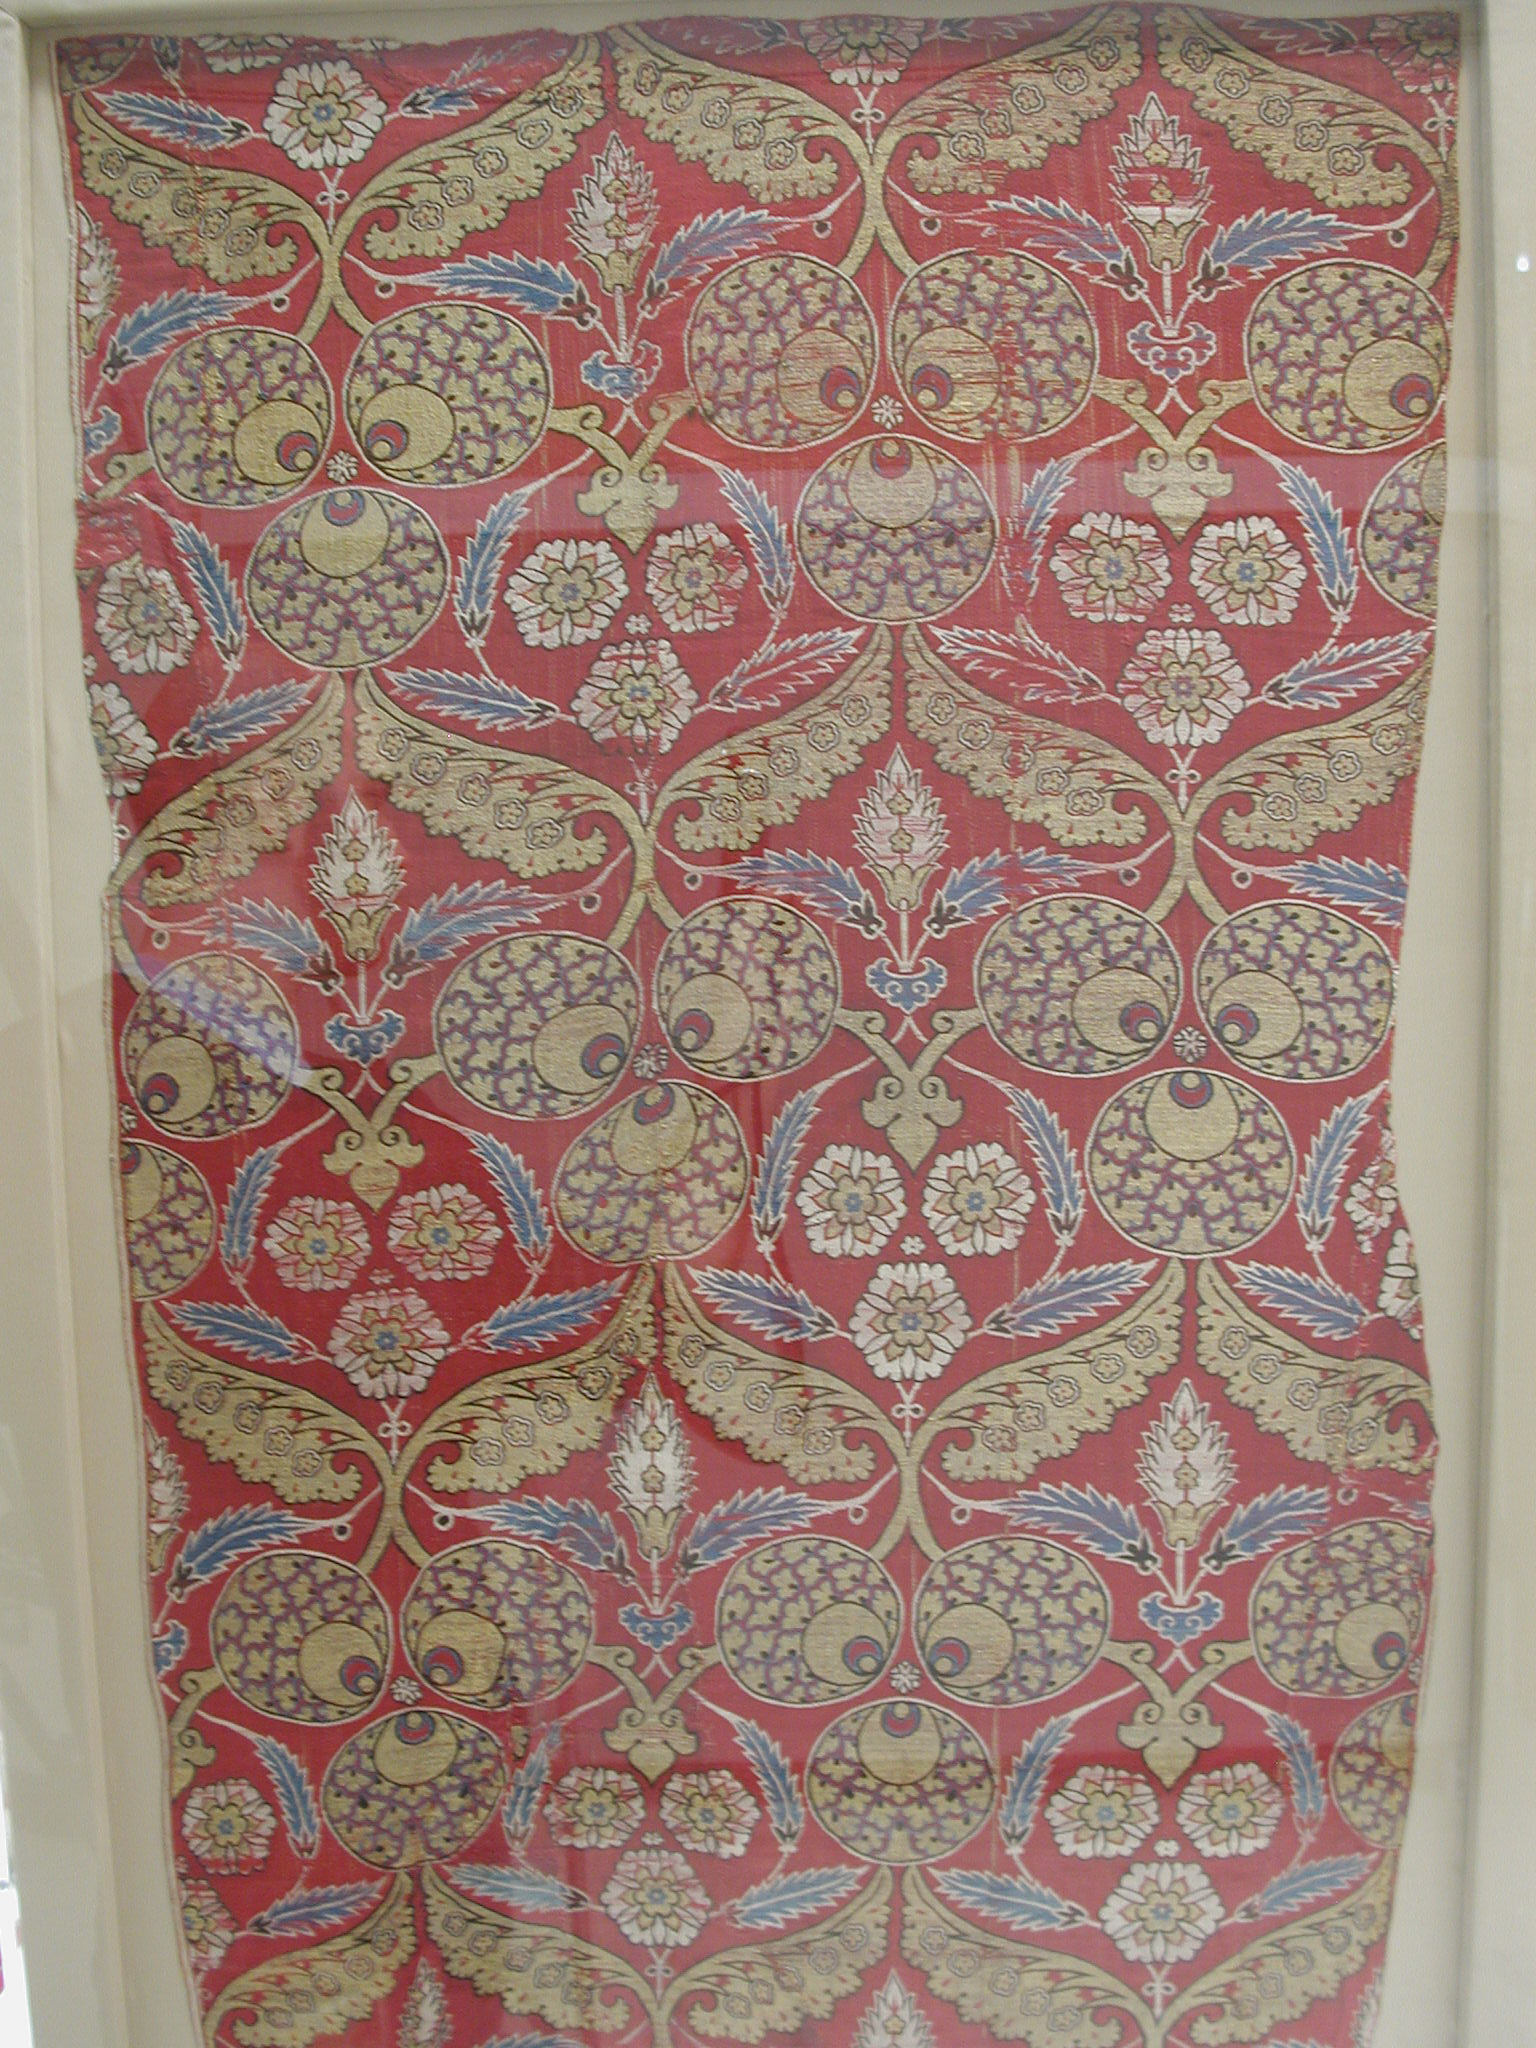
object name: textile fragment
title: Rectangular Silk Fragment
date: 1576-1600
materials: metal thread, silk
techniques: lampas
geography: turkey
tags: flowers,leaves